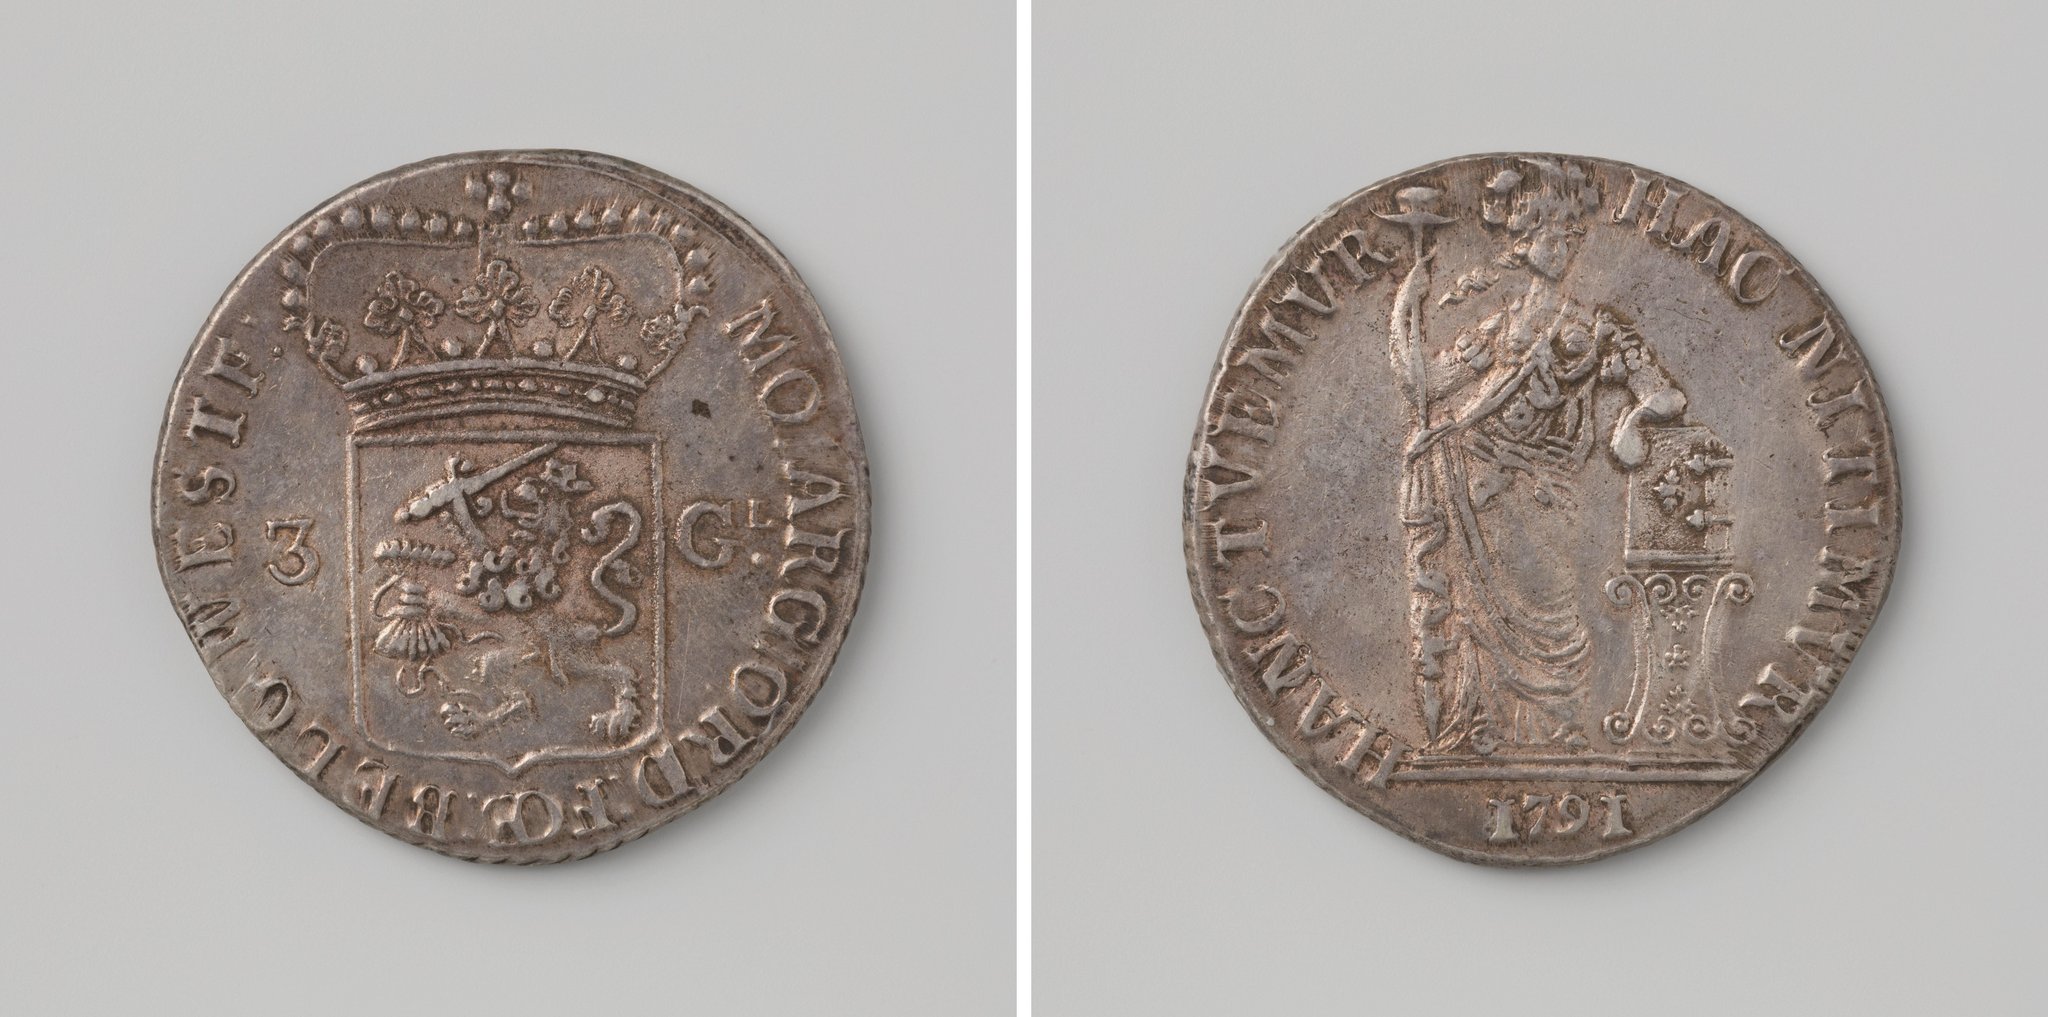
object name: coin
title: Westfriese drie gulden, 1791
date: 1791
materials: silver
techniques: striking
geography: west frisia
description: Zilveren munt. Voorzijde: tussen waarde-aanduiding gekroond generaliteirtswapenschild. Keerzijde: Nederlandse maagd met vrijheidshoed en speer, leunend op een bijbel op een altaar. In afsnede jaartal. Kabelrand.